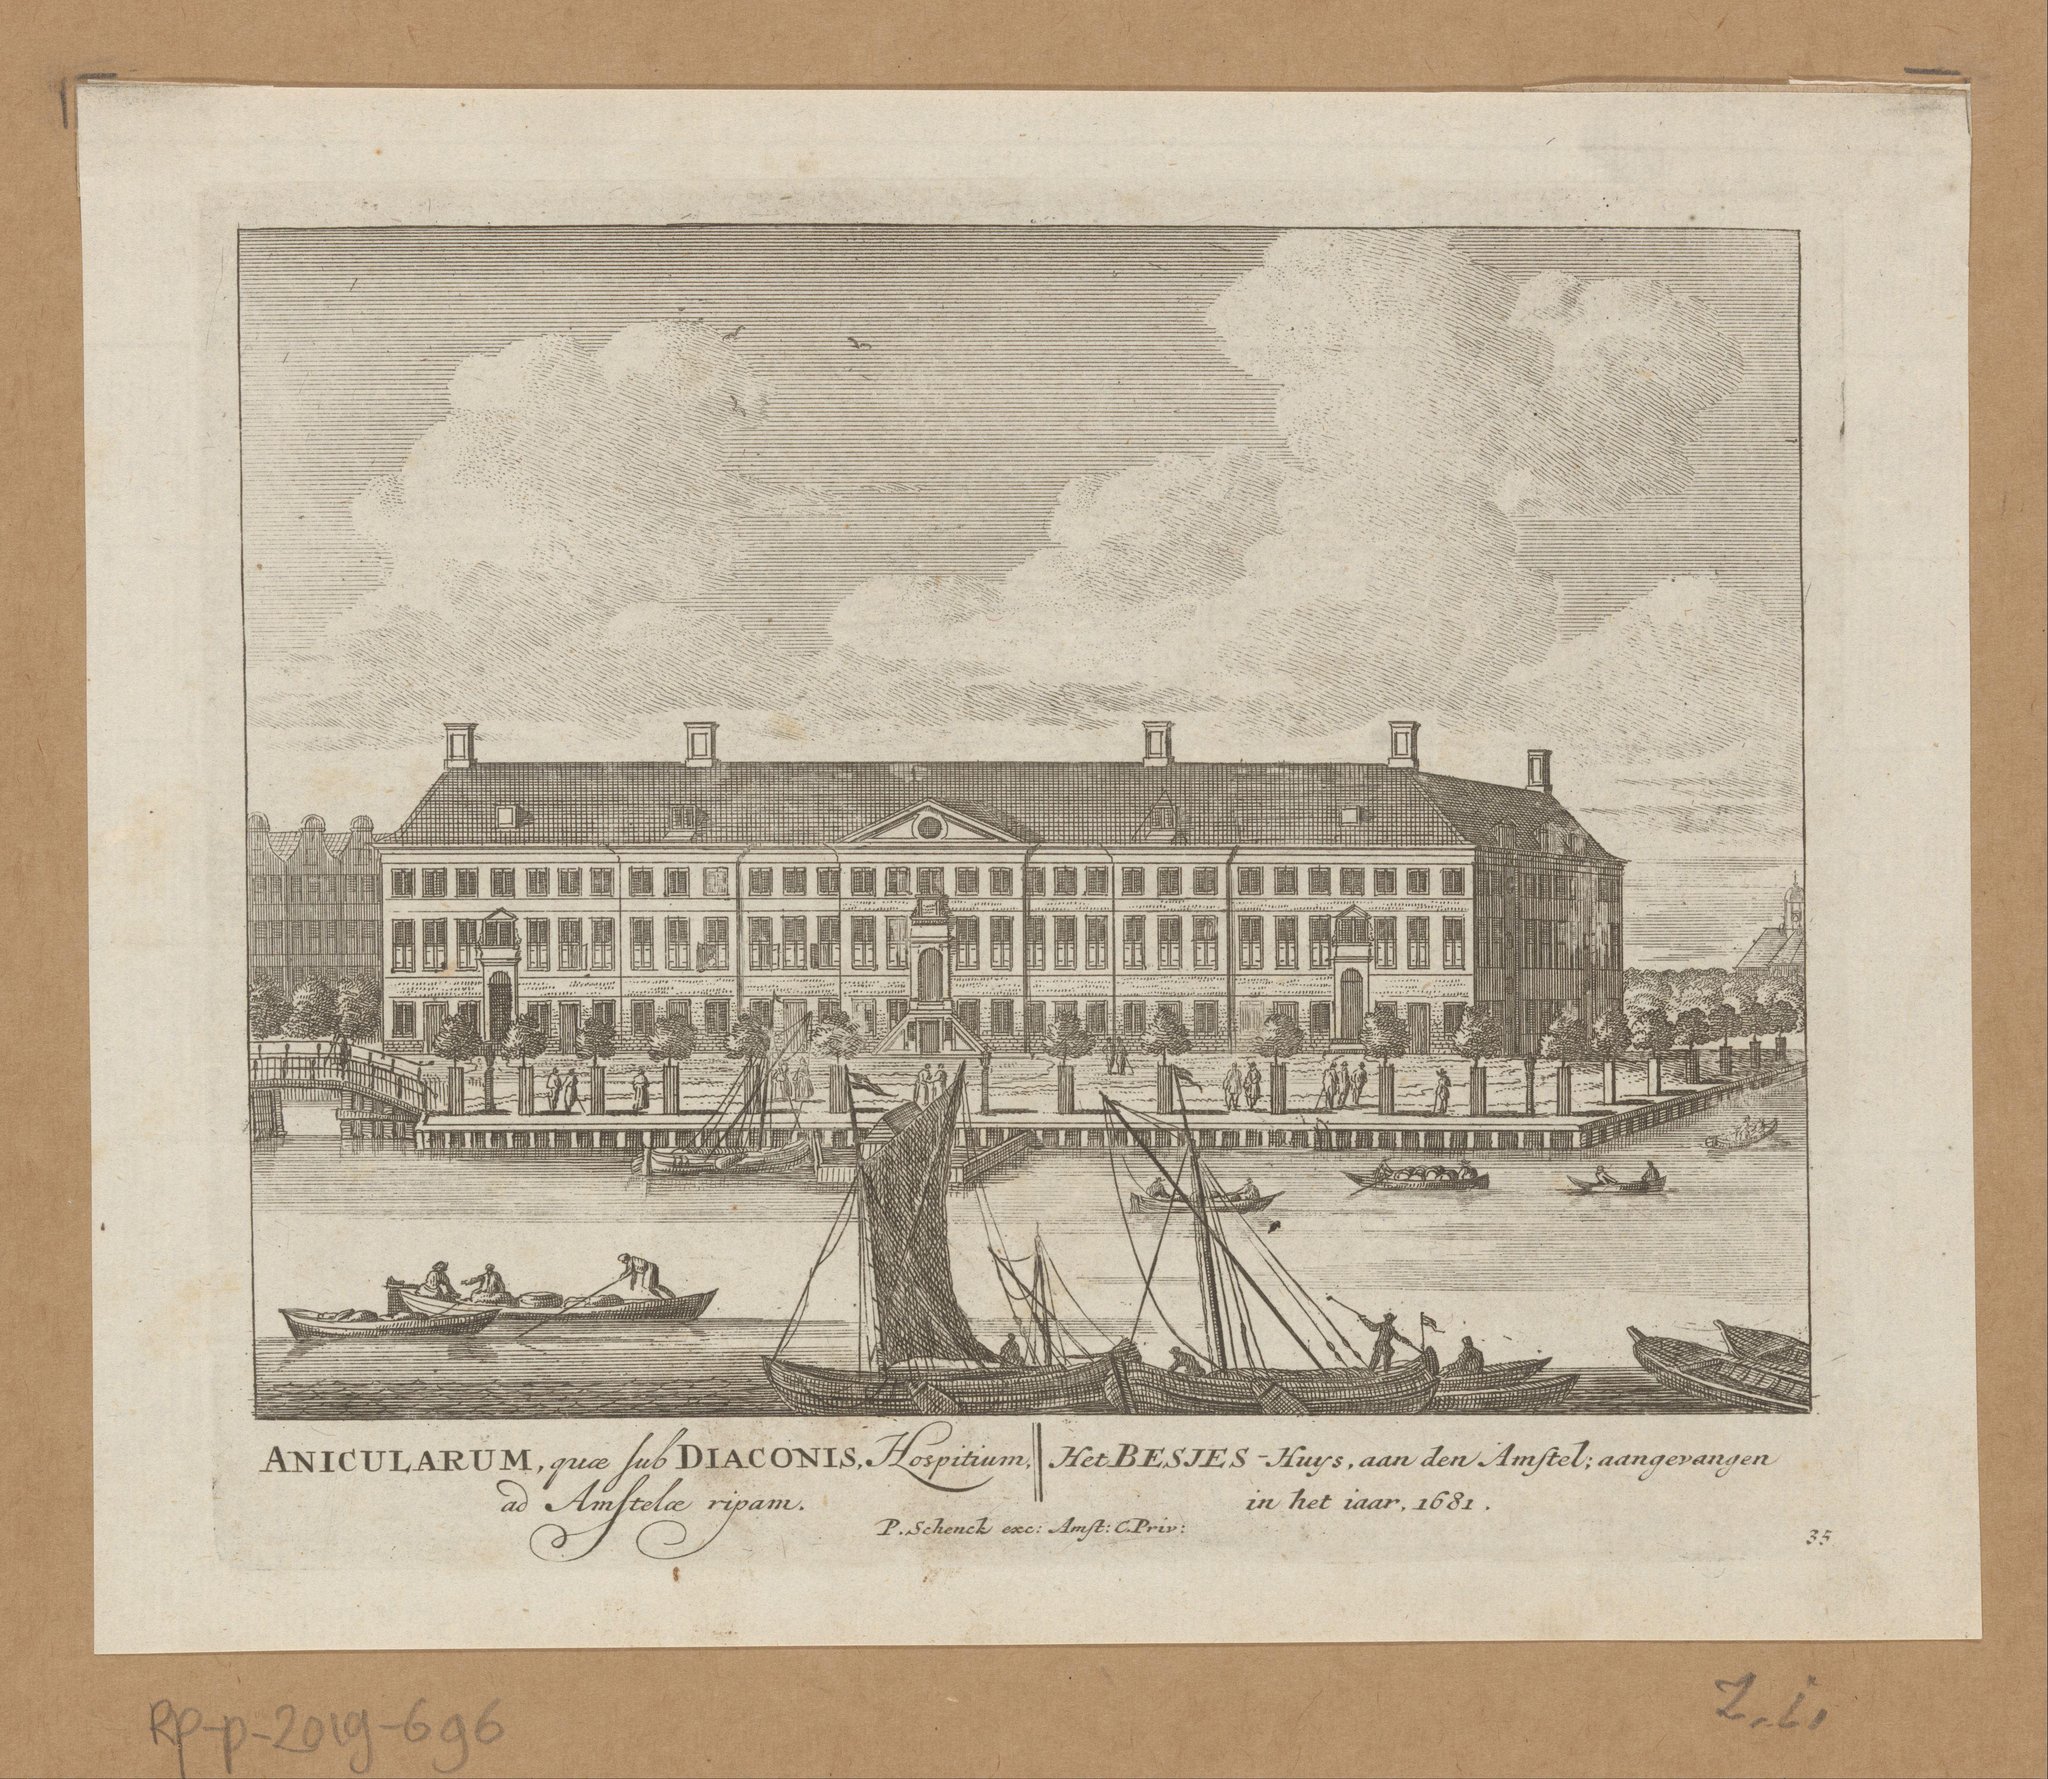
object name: print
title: Anicularum, quae sub Diaconis, Hospitium, ad Amstelae ripam / Het Besjes-Huys, aan den Amstel; aangevangen in het jaar 1681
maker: Anonymous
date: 1710-1711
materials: paper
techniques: etching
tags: public welfare, old-people's home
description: Huidige staat van prent ook gebruikt in: 100 Afbeeldinge der voornaamste gebouwen van Amsterdam. Amsterdam: Pieter Schenk (I), s.a. [1710-1711]. En in: 100 Afbeeldinge der voornaamste gebouwen van Amsterdam. Amsterdam: Barent Greve, s.a. [1757-1766].* *In de tweede uitgave, uitgegeven door Barent Greve, is alleen de titelprent aangepast. De overige prenten zijn onveranderd gebleven.